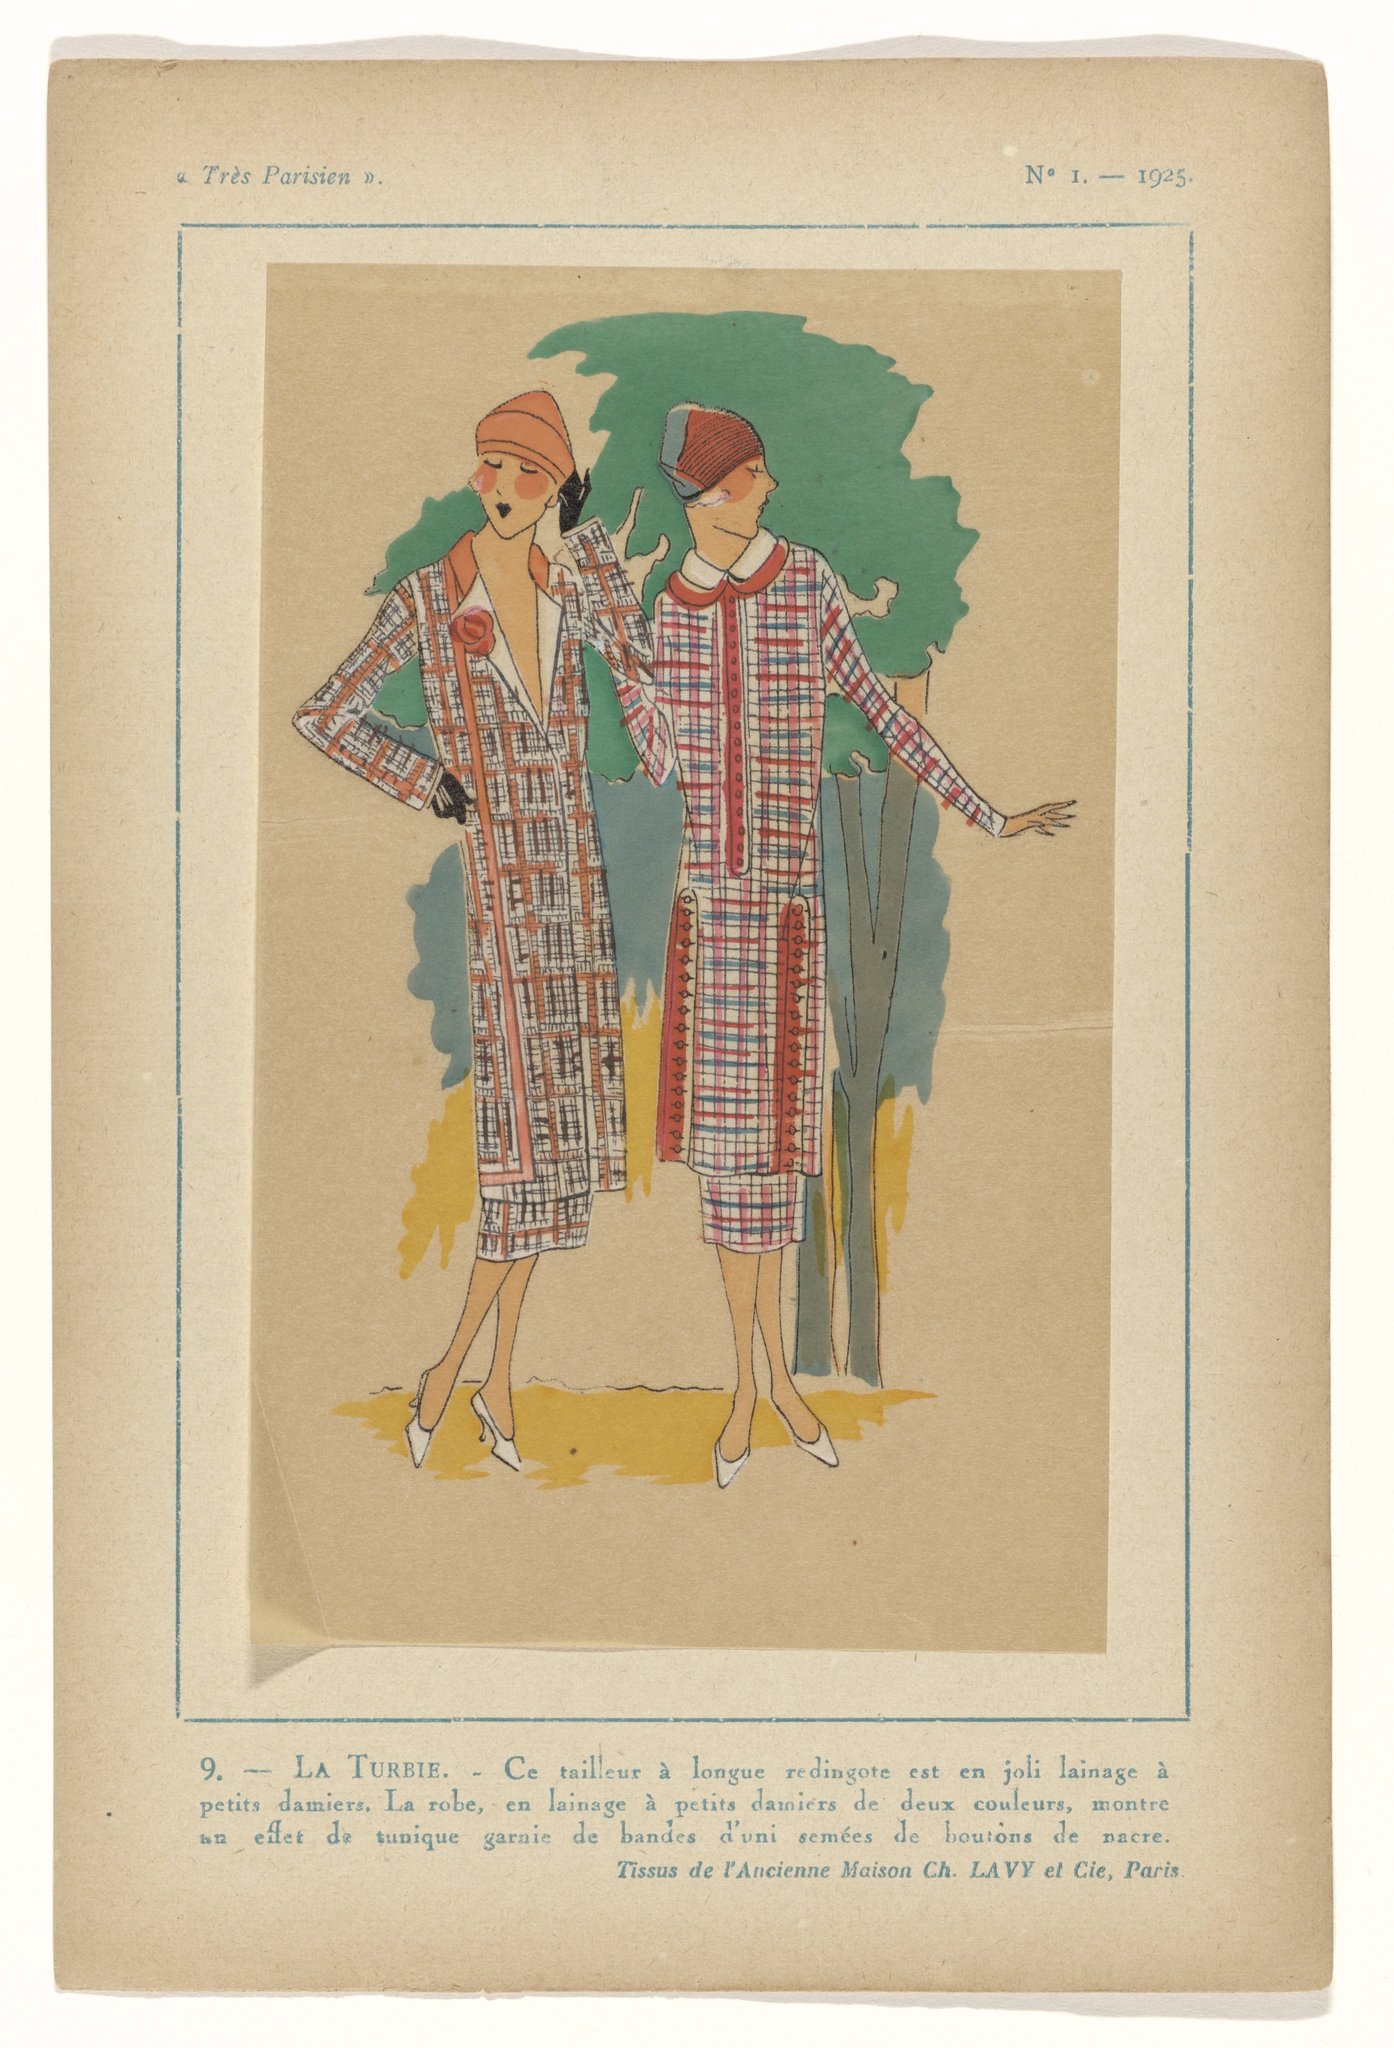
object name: fashion print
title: Très Parisien, 1925, No. 1, Pl. 9.- LA TURBIE.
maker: g-p. joumard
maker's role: publisher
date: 1925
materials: paper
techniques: hand coloring, letterpress printing, lithography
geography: paris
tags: ensembles of pieces of clothing (tailleur) (+ women's clothes), head-gear: cap (+ women's clothes), fashion plates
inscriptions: caption: ‘LA TURBIE -. Ce tailleur à longue redingote est en joli lainage à petits damiers. La robe, en lainage à petits damiers de deux couleurs, montre un effet de tunique garnie de bandes d'uni semées de boutons de nacre. Tissus de l'Ancienne maison Ch. Lavy et Cie, Paris’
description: Mantelpak met lange jas (redingote) en wollen japon afgezet met band. Stoffen van Maison Ch. Lavy in Paijs. Prent uit het modetijdschrift Très Parisien...La Mode, Le Chic, L'Élégance (1920-1936)